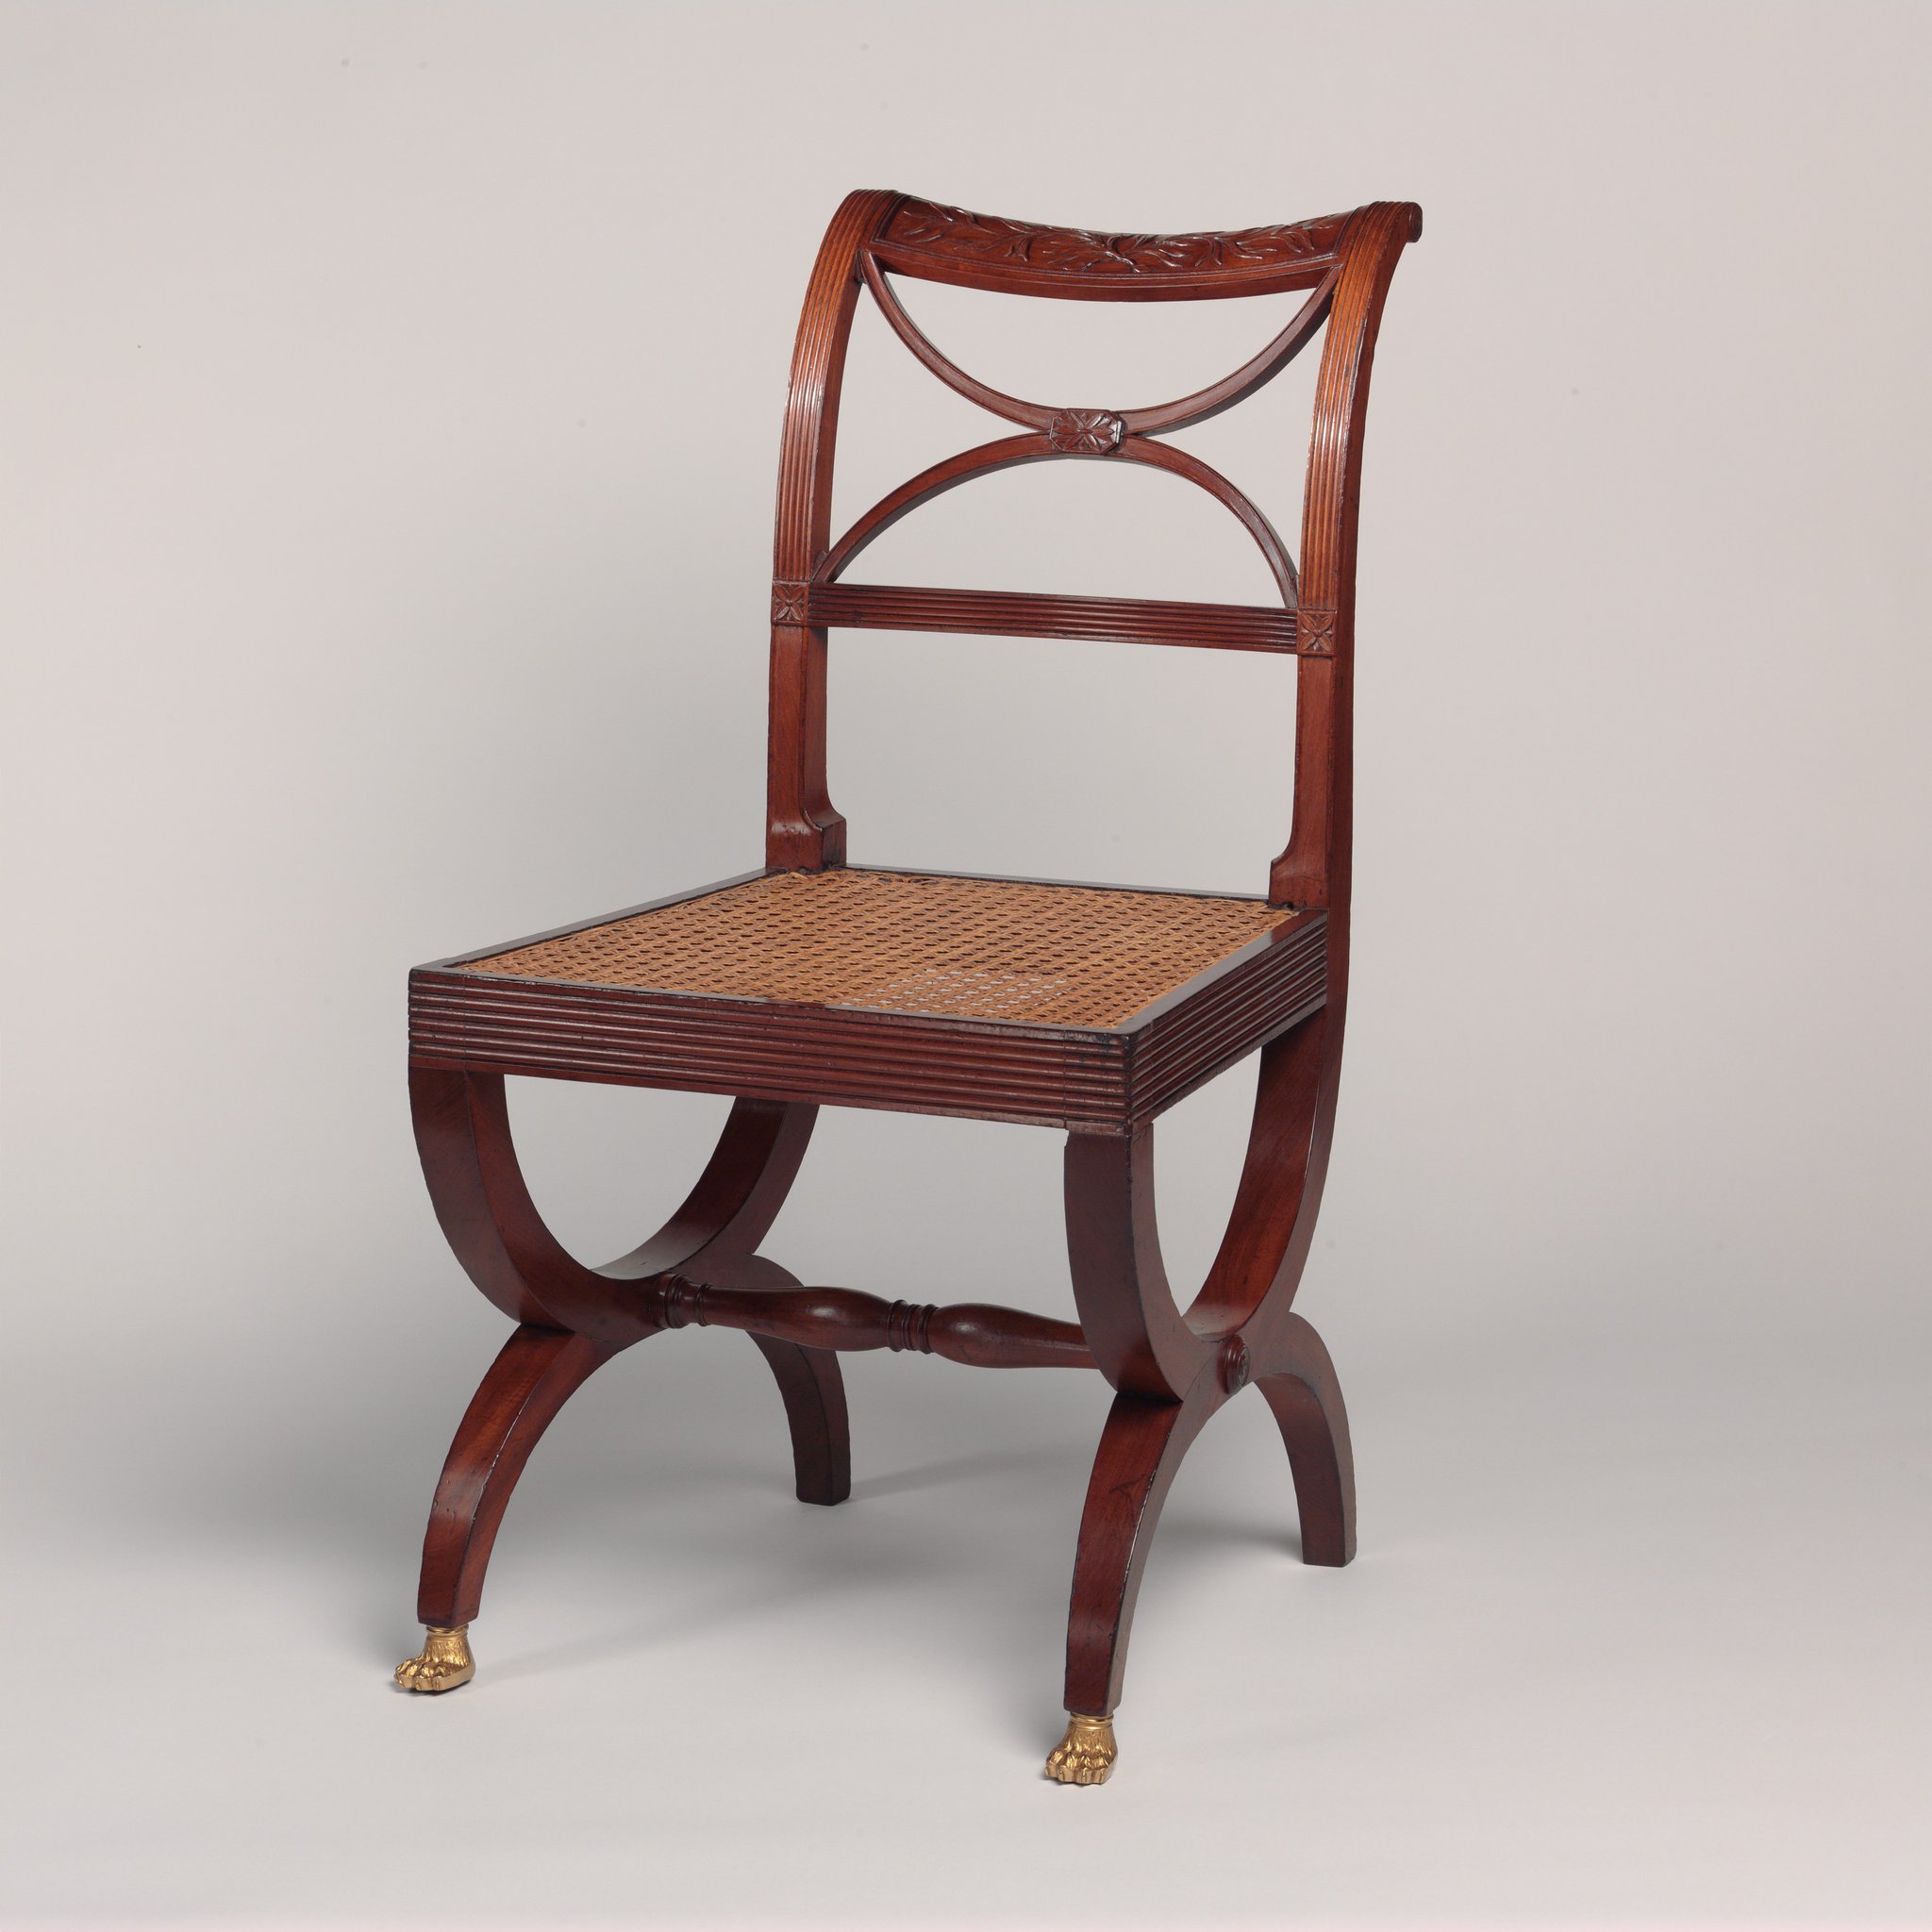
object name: side chair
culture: american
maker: duncan phyfe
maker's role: maker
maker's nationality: american, born scotland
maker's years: 1770-1854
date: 1791-1818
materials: brass, wood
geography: united states